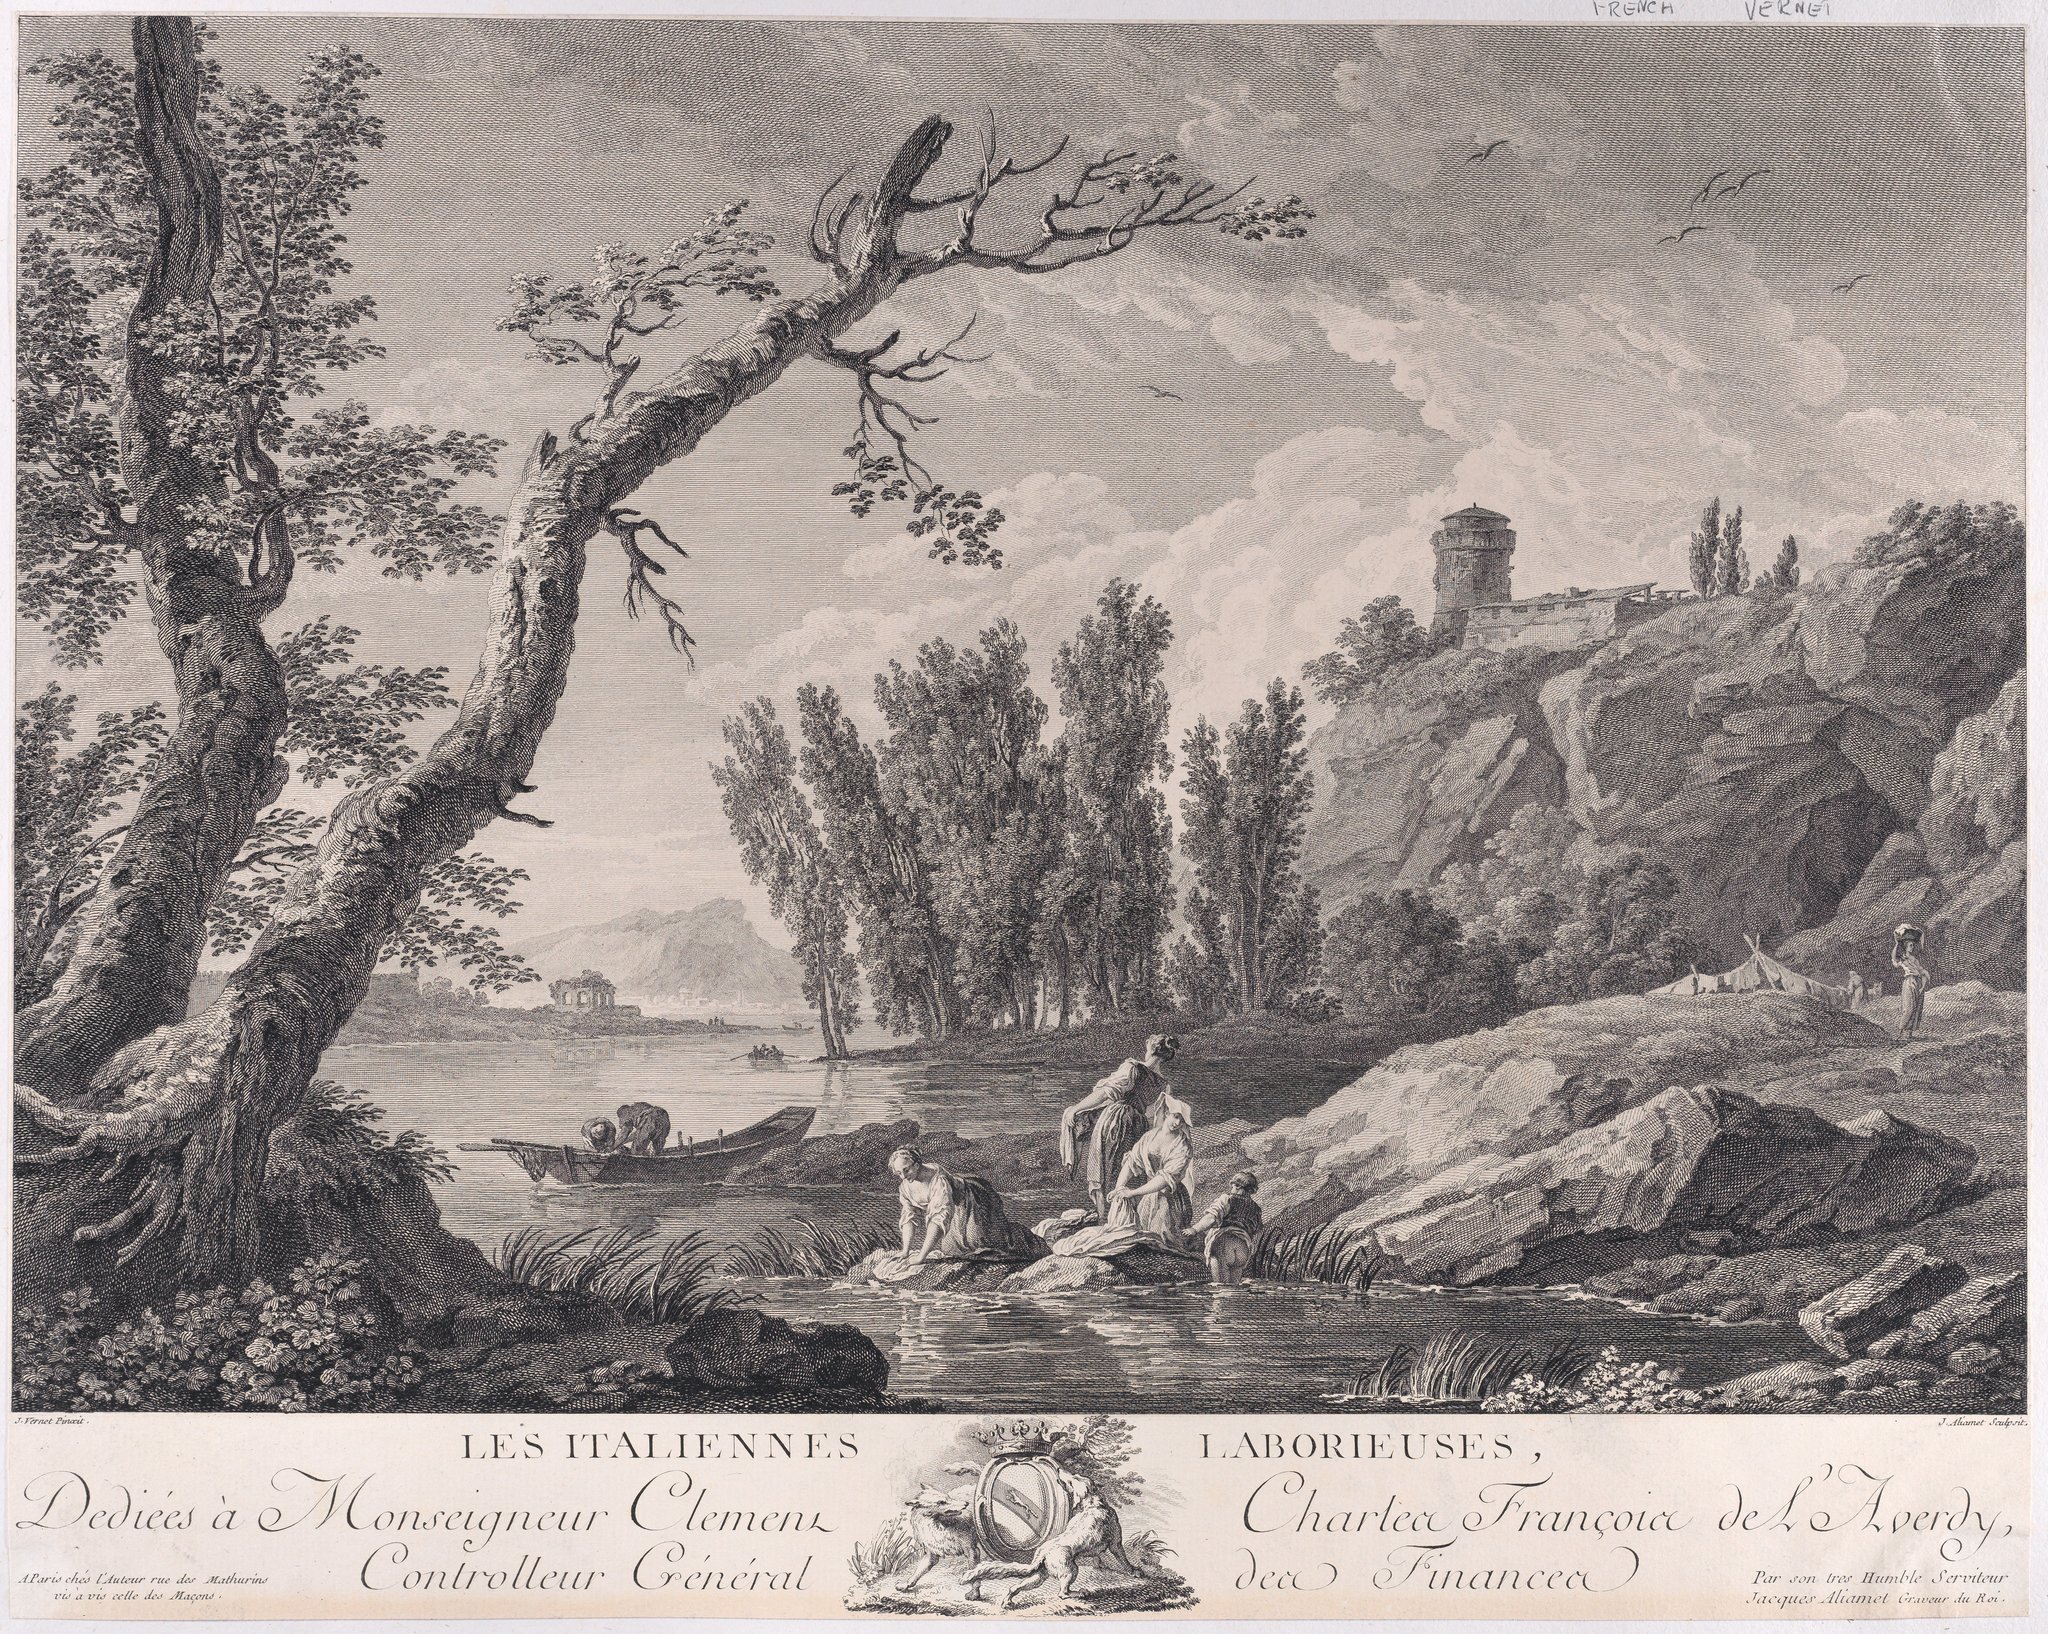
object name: print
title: The Laboring Italian Women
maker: joseph vernet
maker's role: artist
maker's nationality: french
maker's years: 1714-1789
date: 1765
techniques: engraving